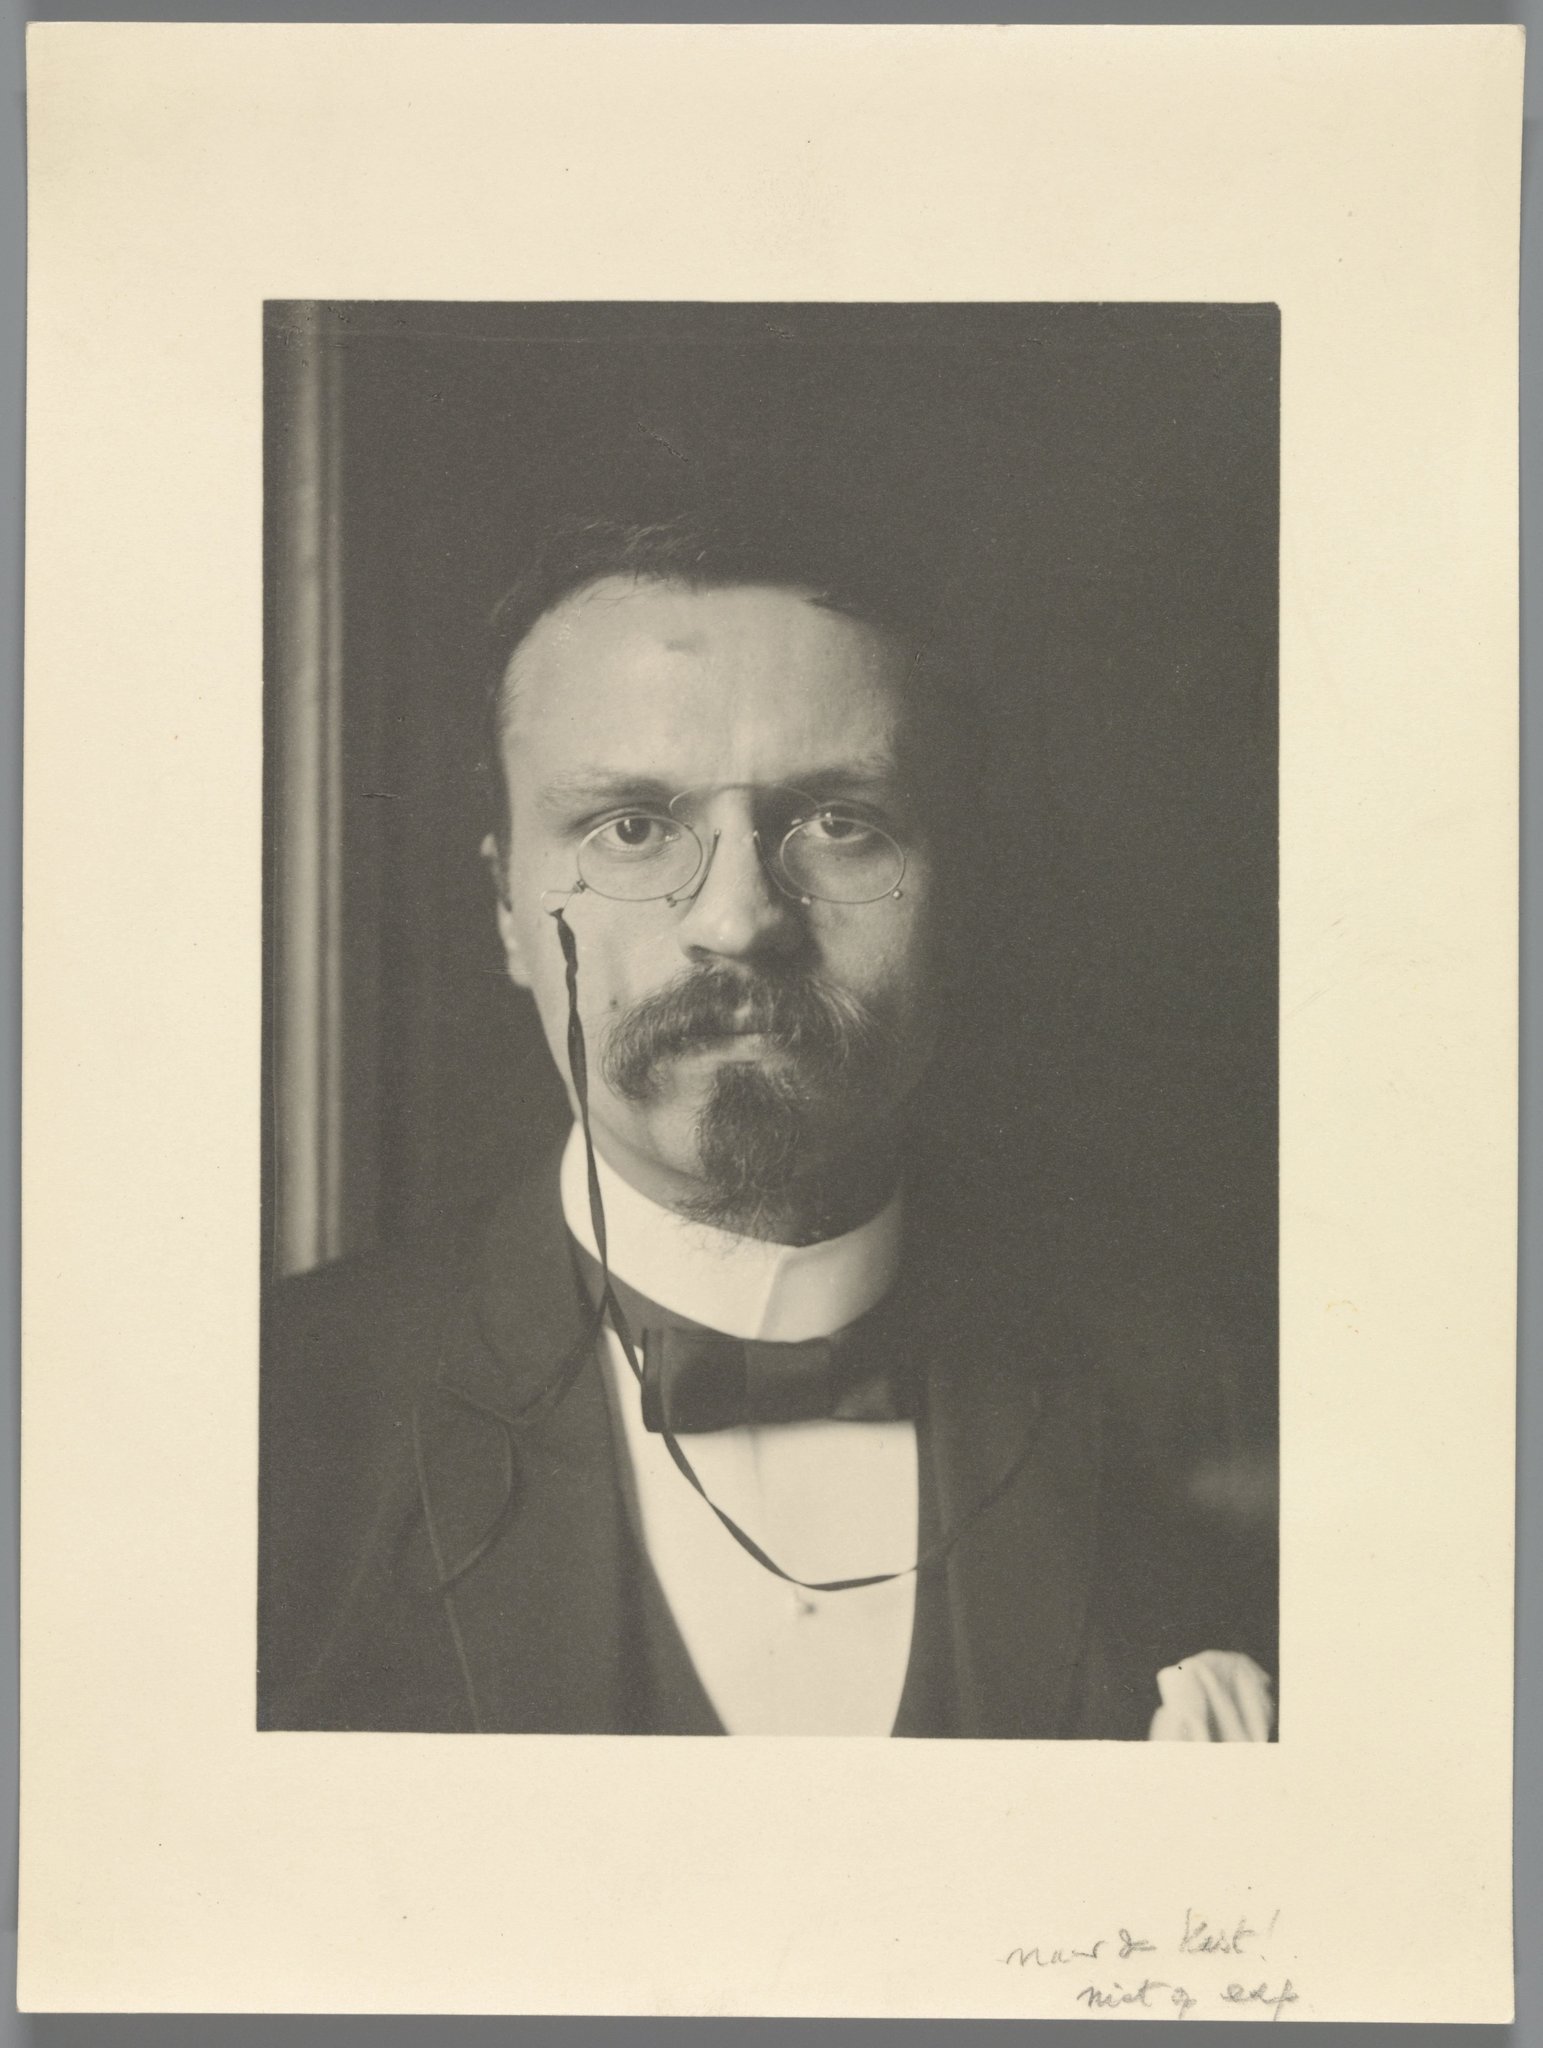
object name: photograph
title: Reproductie naar een foto van Willem Witsen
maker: Anonymous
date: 1860-1915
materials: paper, photographic support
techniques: gelatin silver print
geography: netherlands